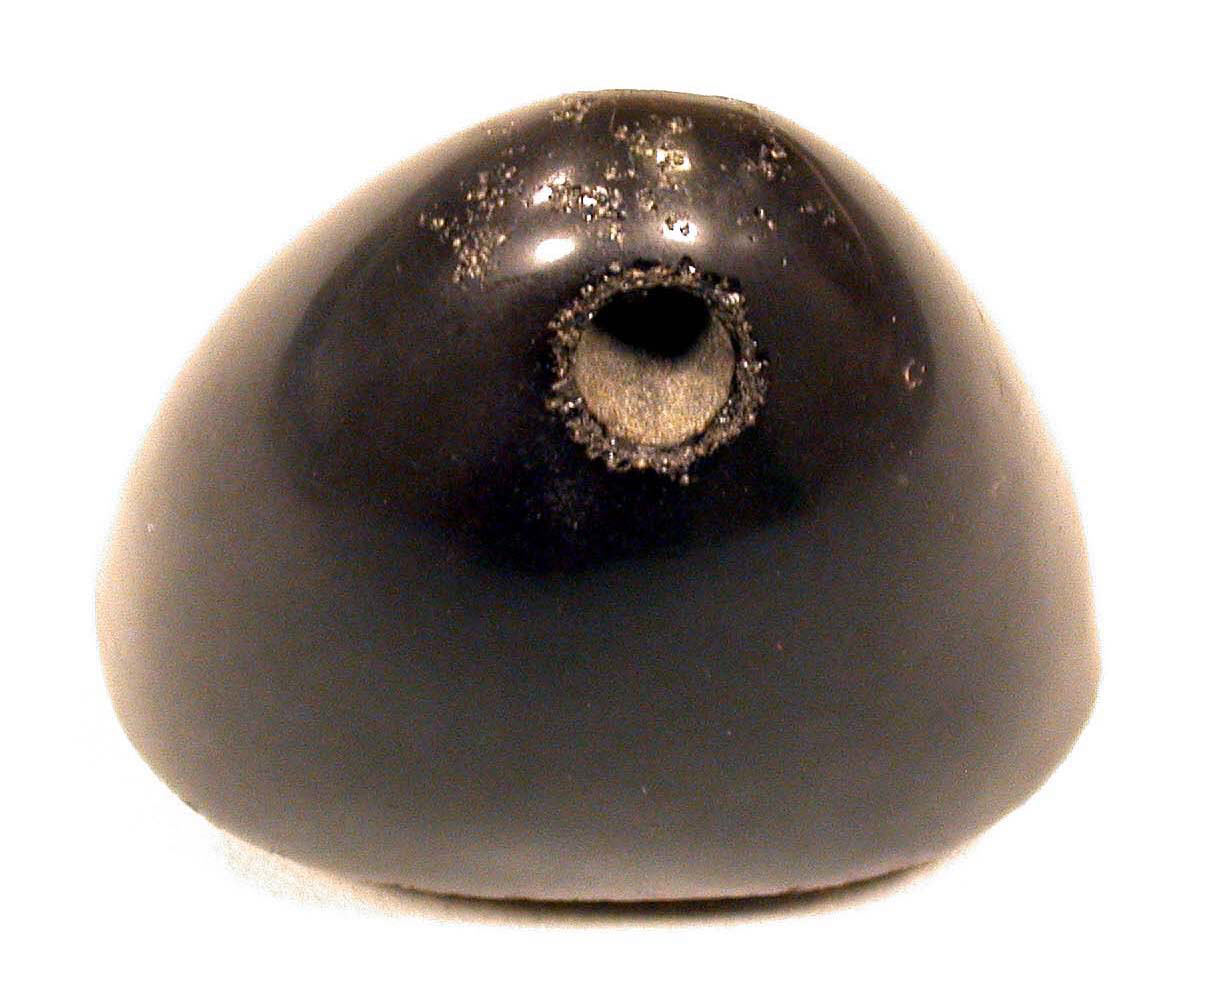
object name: pendant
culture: mexican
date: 1501-1600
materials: obsidian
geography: mexico